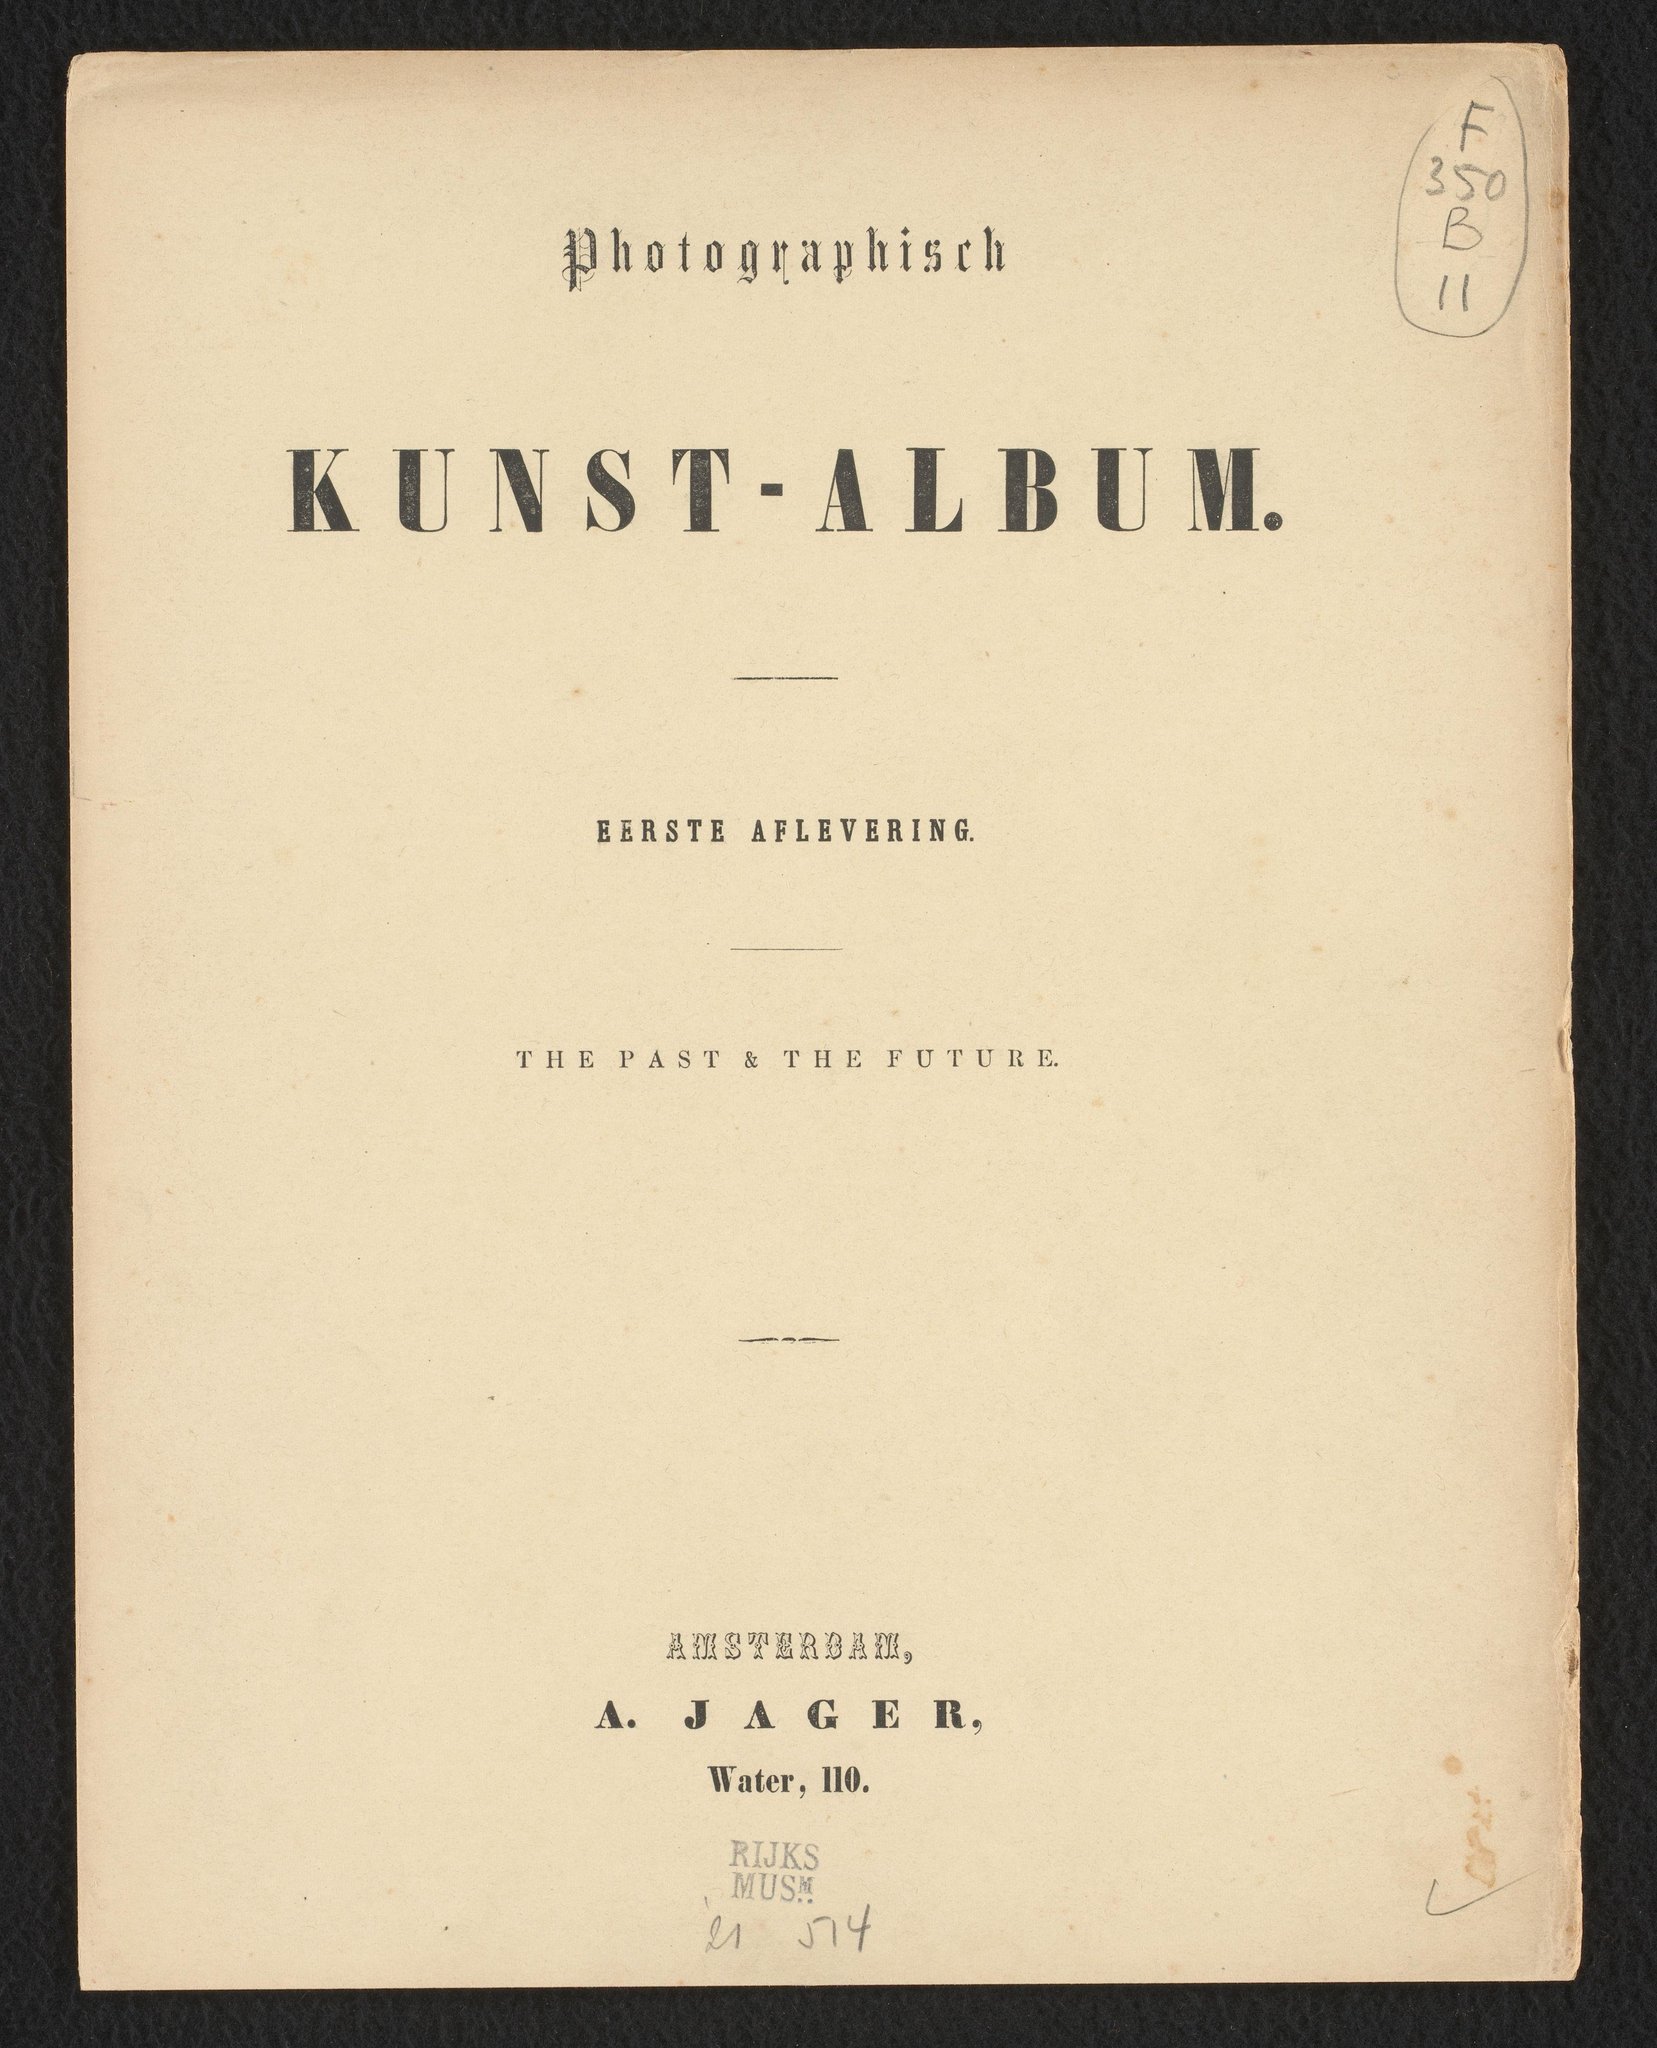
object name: photograph album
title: Omslag met twaalf kunstreproducties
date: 1857-1885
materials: cardboard, linen, paper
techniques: albumen print, decorated paper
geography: amsterdam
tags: painting (including book-illumination, miniature-painting)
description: Omslag met twaalf dubbele omslagen met daarin elf albuminedrukken met kunstreproducties. Het eerste omslag bevat geen foto.